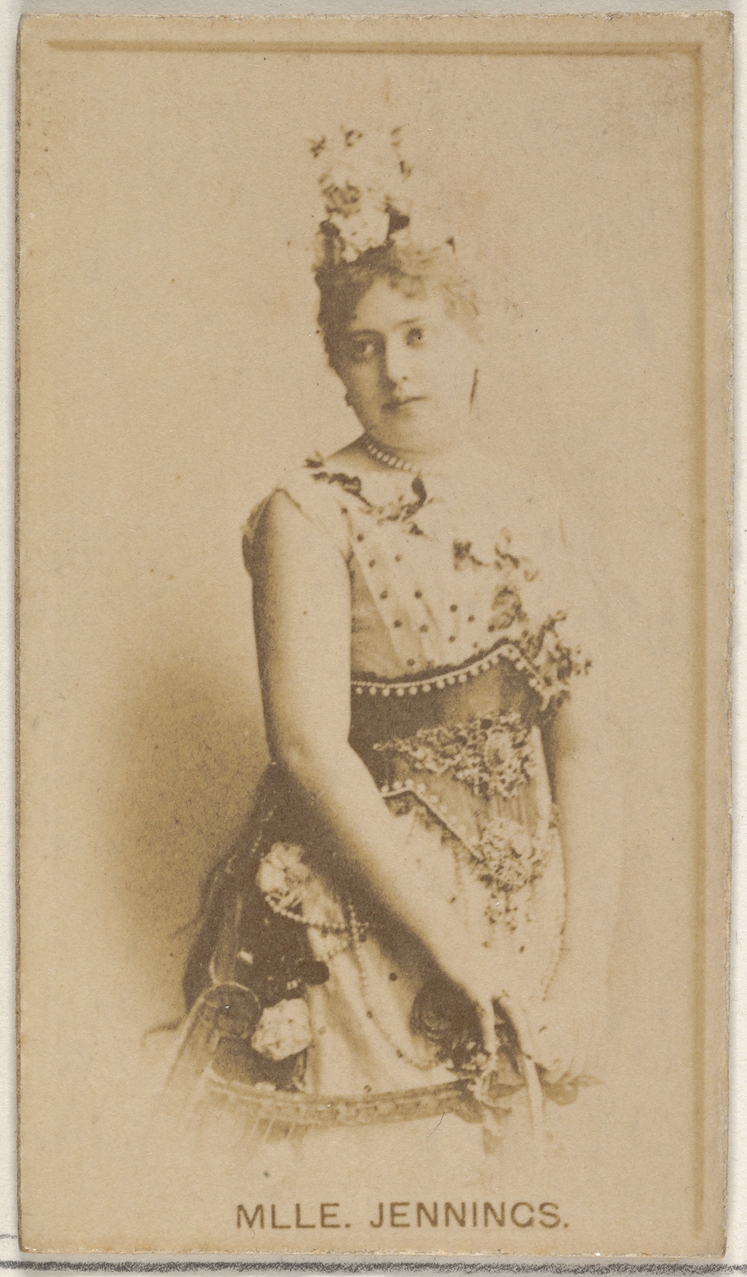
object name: photograph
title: Mlle. Jennings, from the Actors and Actresses series (N45, Type 8) for Virginia Brights Cigarettes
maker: allen & ginter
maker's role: publisher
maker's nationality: american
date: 1888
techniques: albumen silver print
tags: portraits,women,actresses